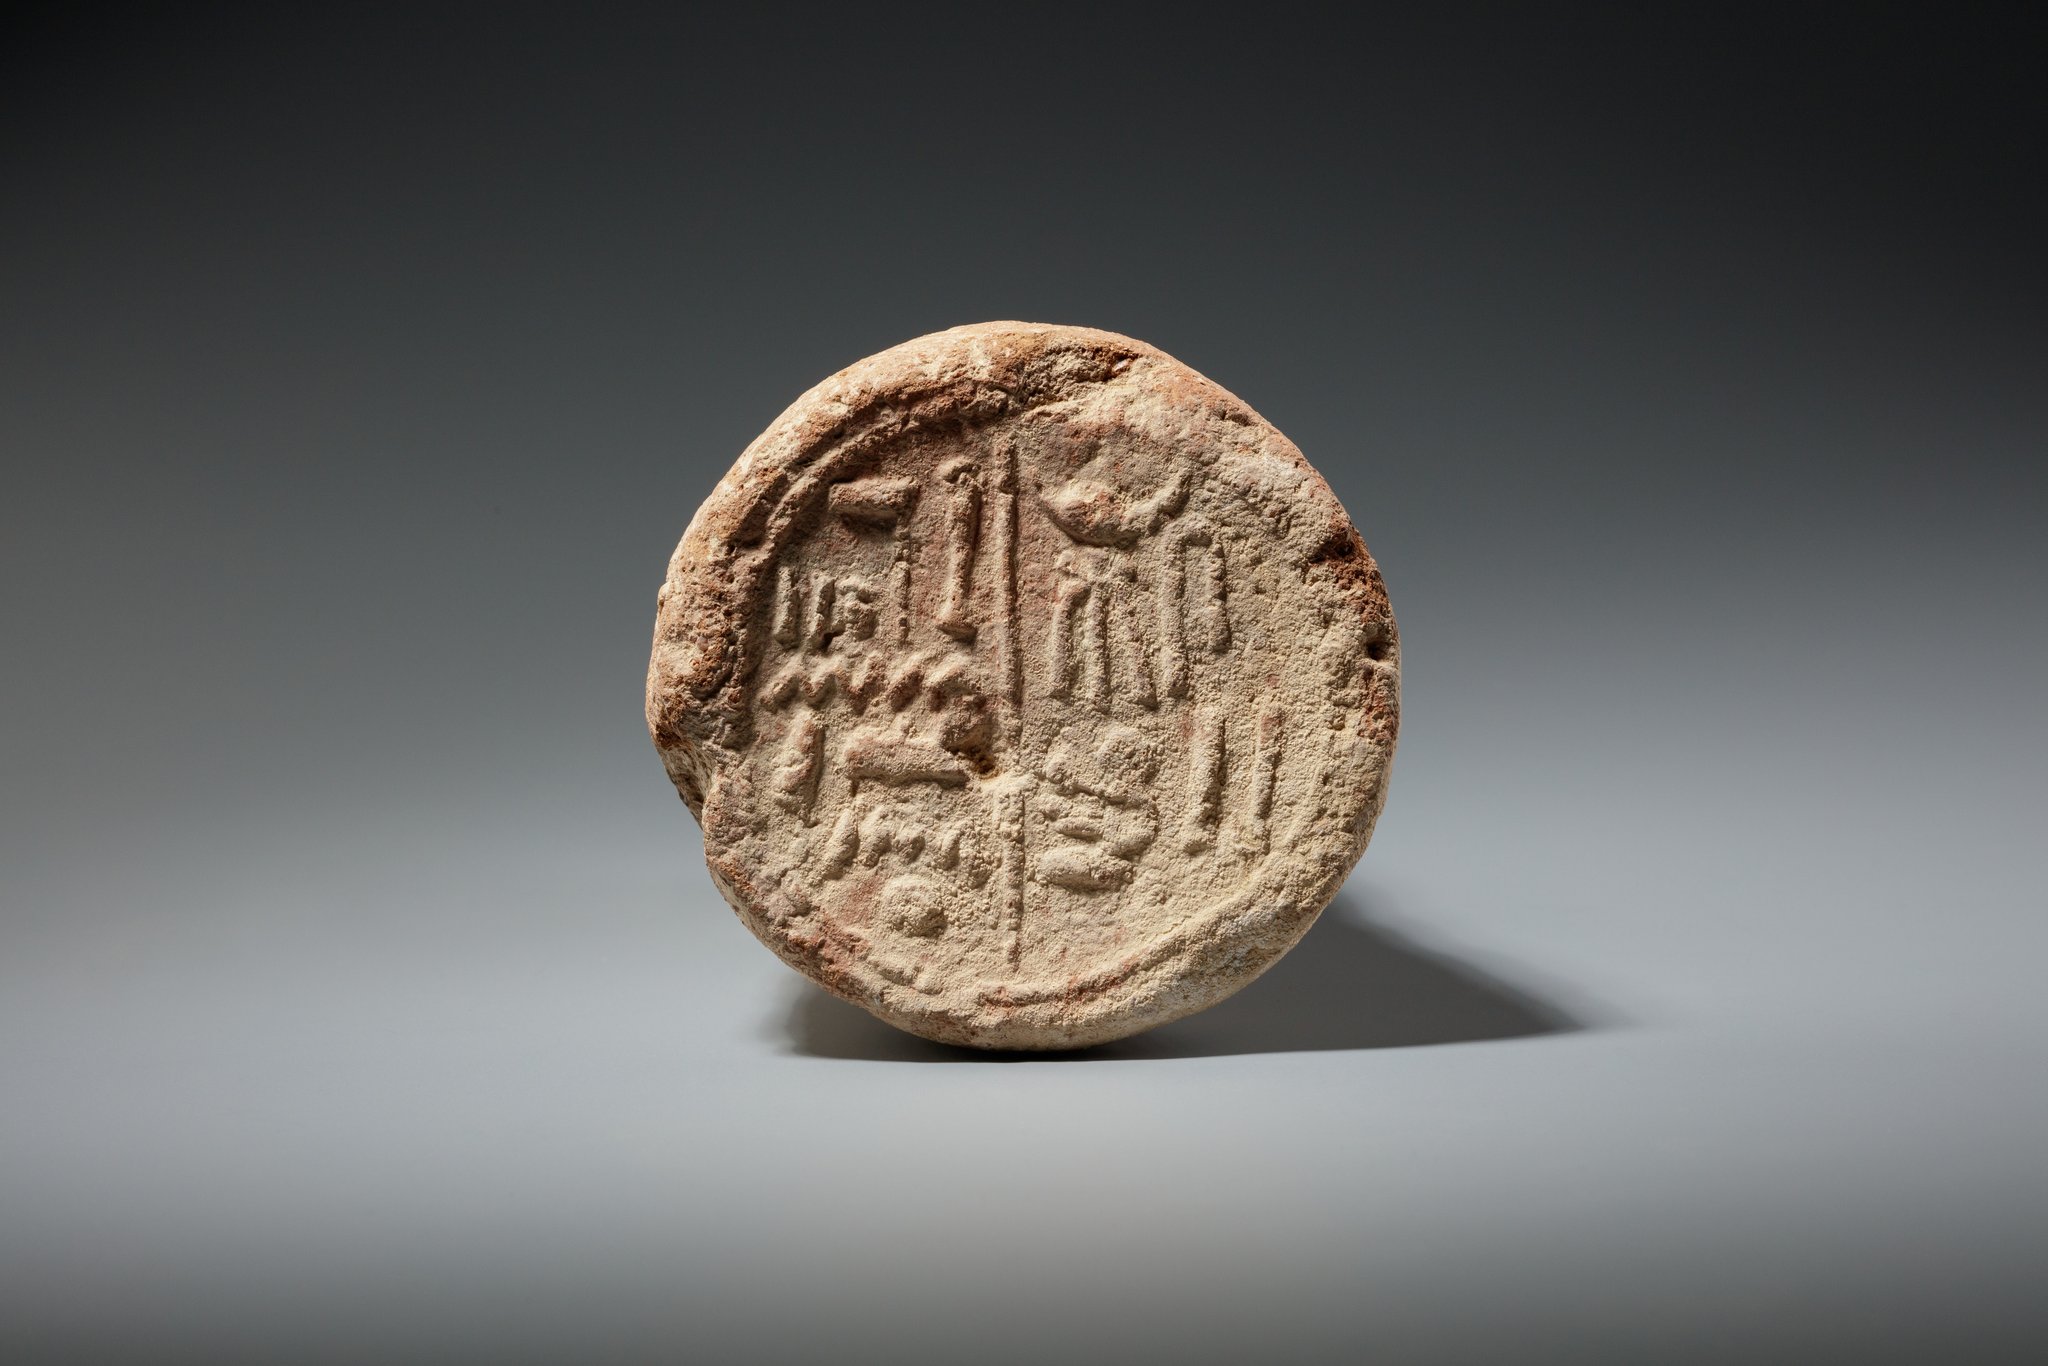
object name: cone, davy 300, ahmose, high priest, amun, thutmose iii, tt 121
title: Funerary Cone of the High Priest Ahmose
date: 1479-1425 BCE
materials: pottery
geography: egypt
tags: hieroglyphs